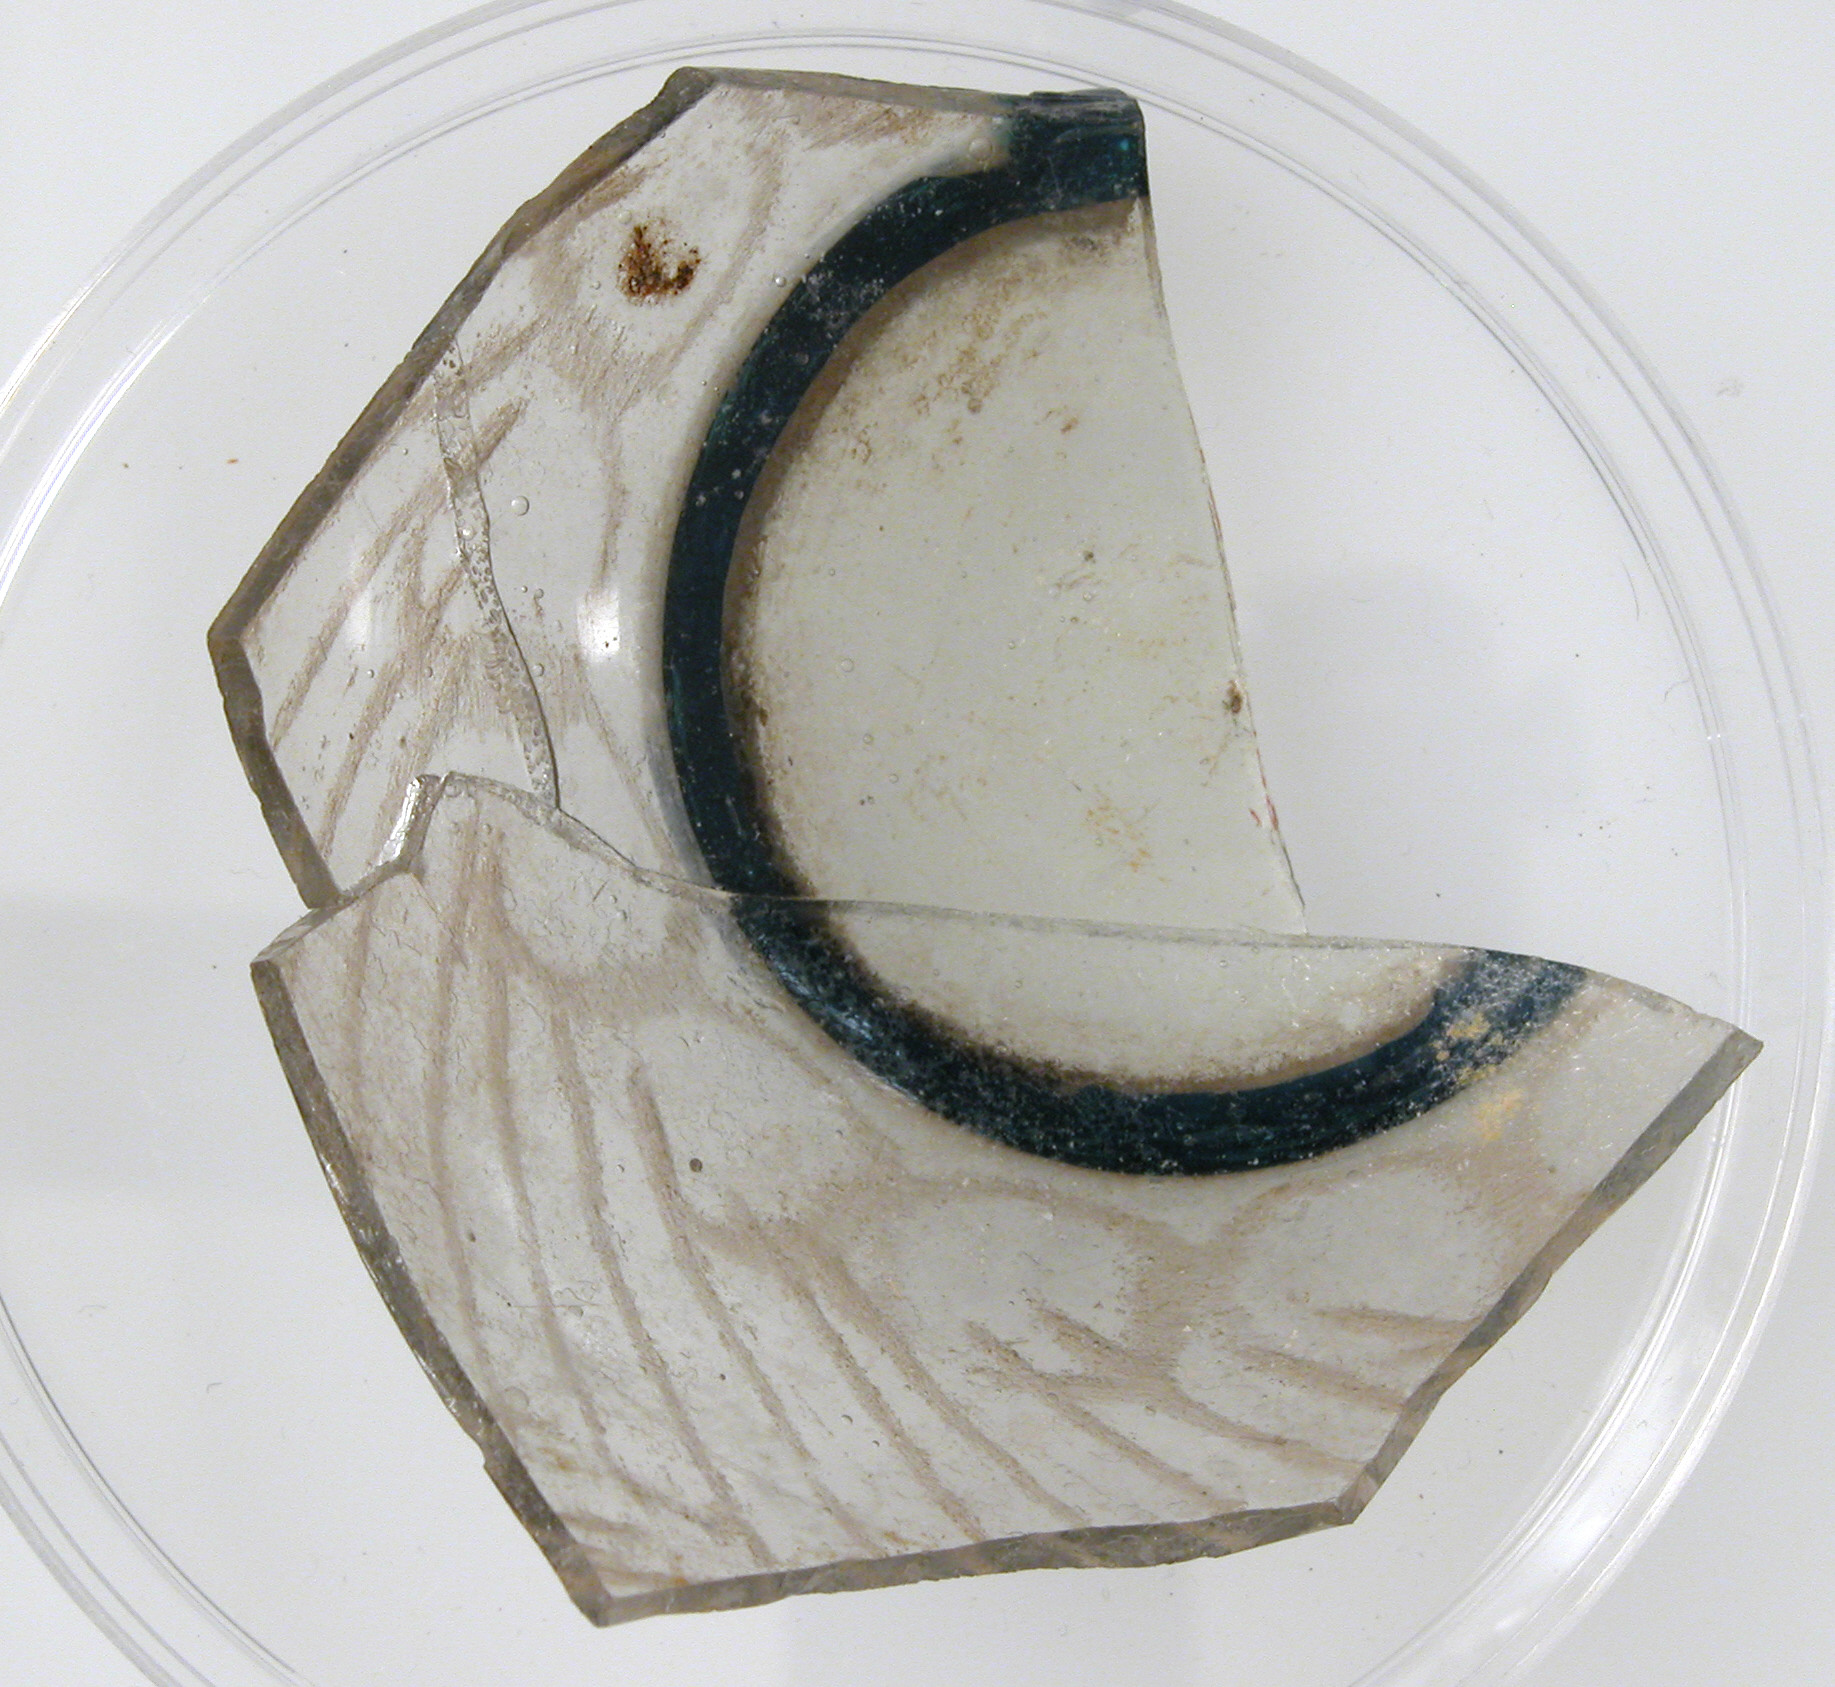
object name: fragment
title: Bottom of a Vessel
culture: coptic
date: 301-433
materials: glass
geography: egypt